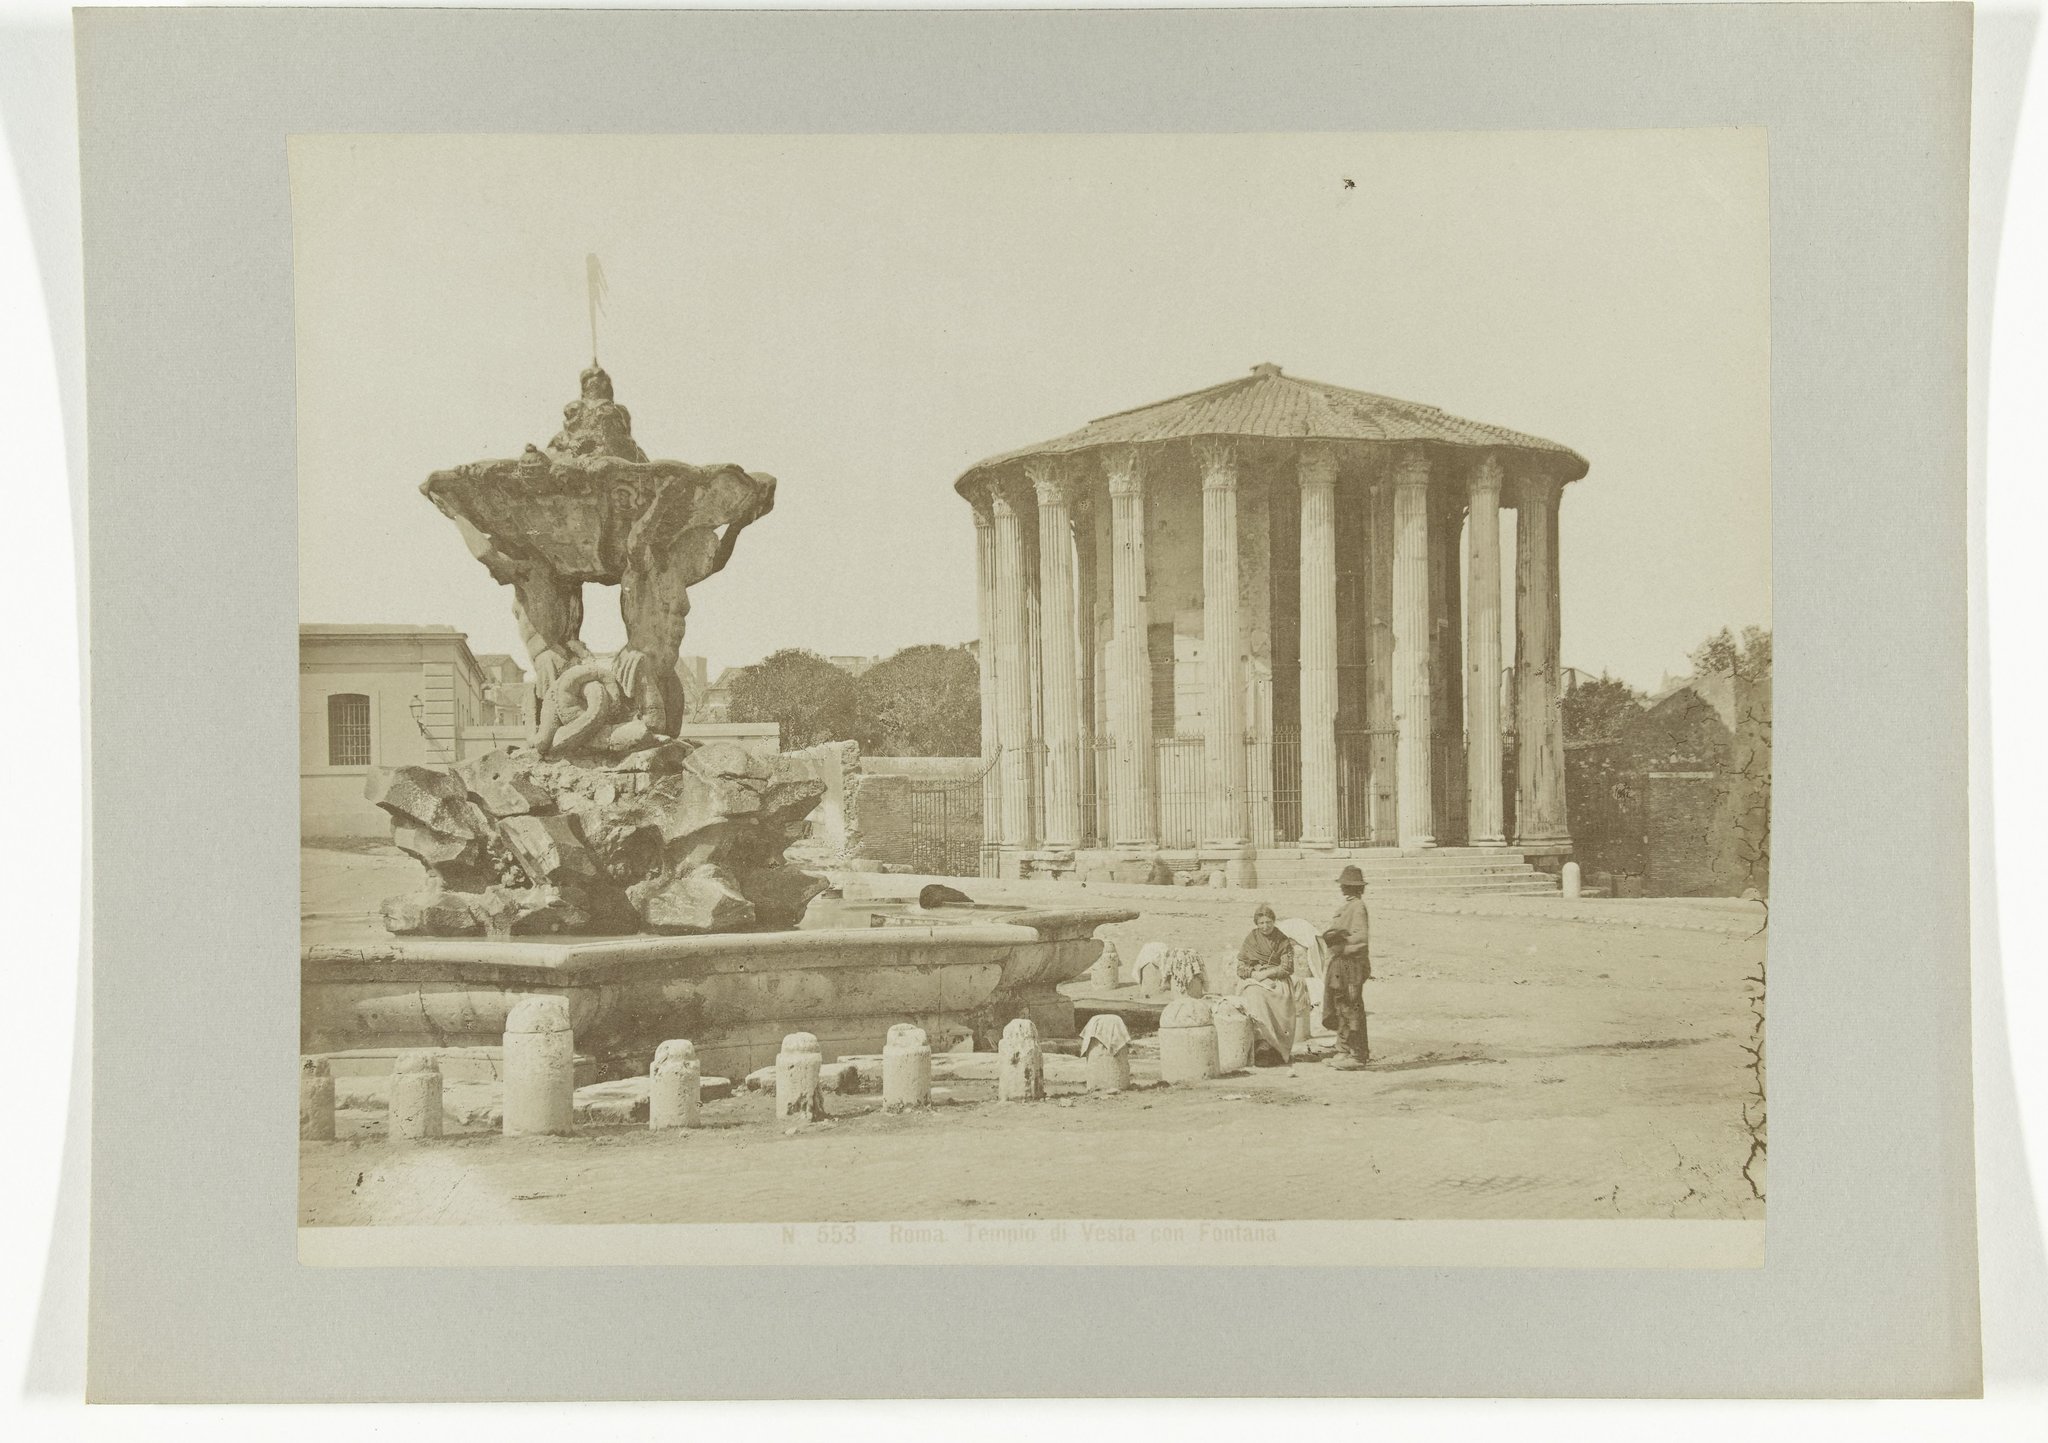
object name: photograph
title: N. 553. Roma. Tempio di Vesta con Fontana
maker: Anonymous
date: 1880-1904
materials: cardboard, paper, photographic support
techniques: albumen print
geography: rome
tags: garden fountain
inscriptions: number: ‘36.’